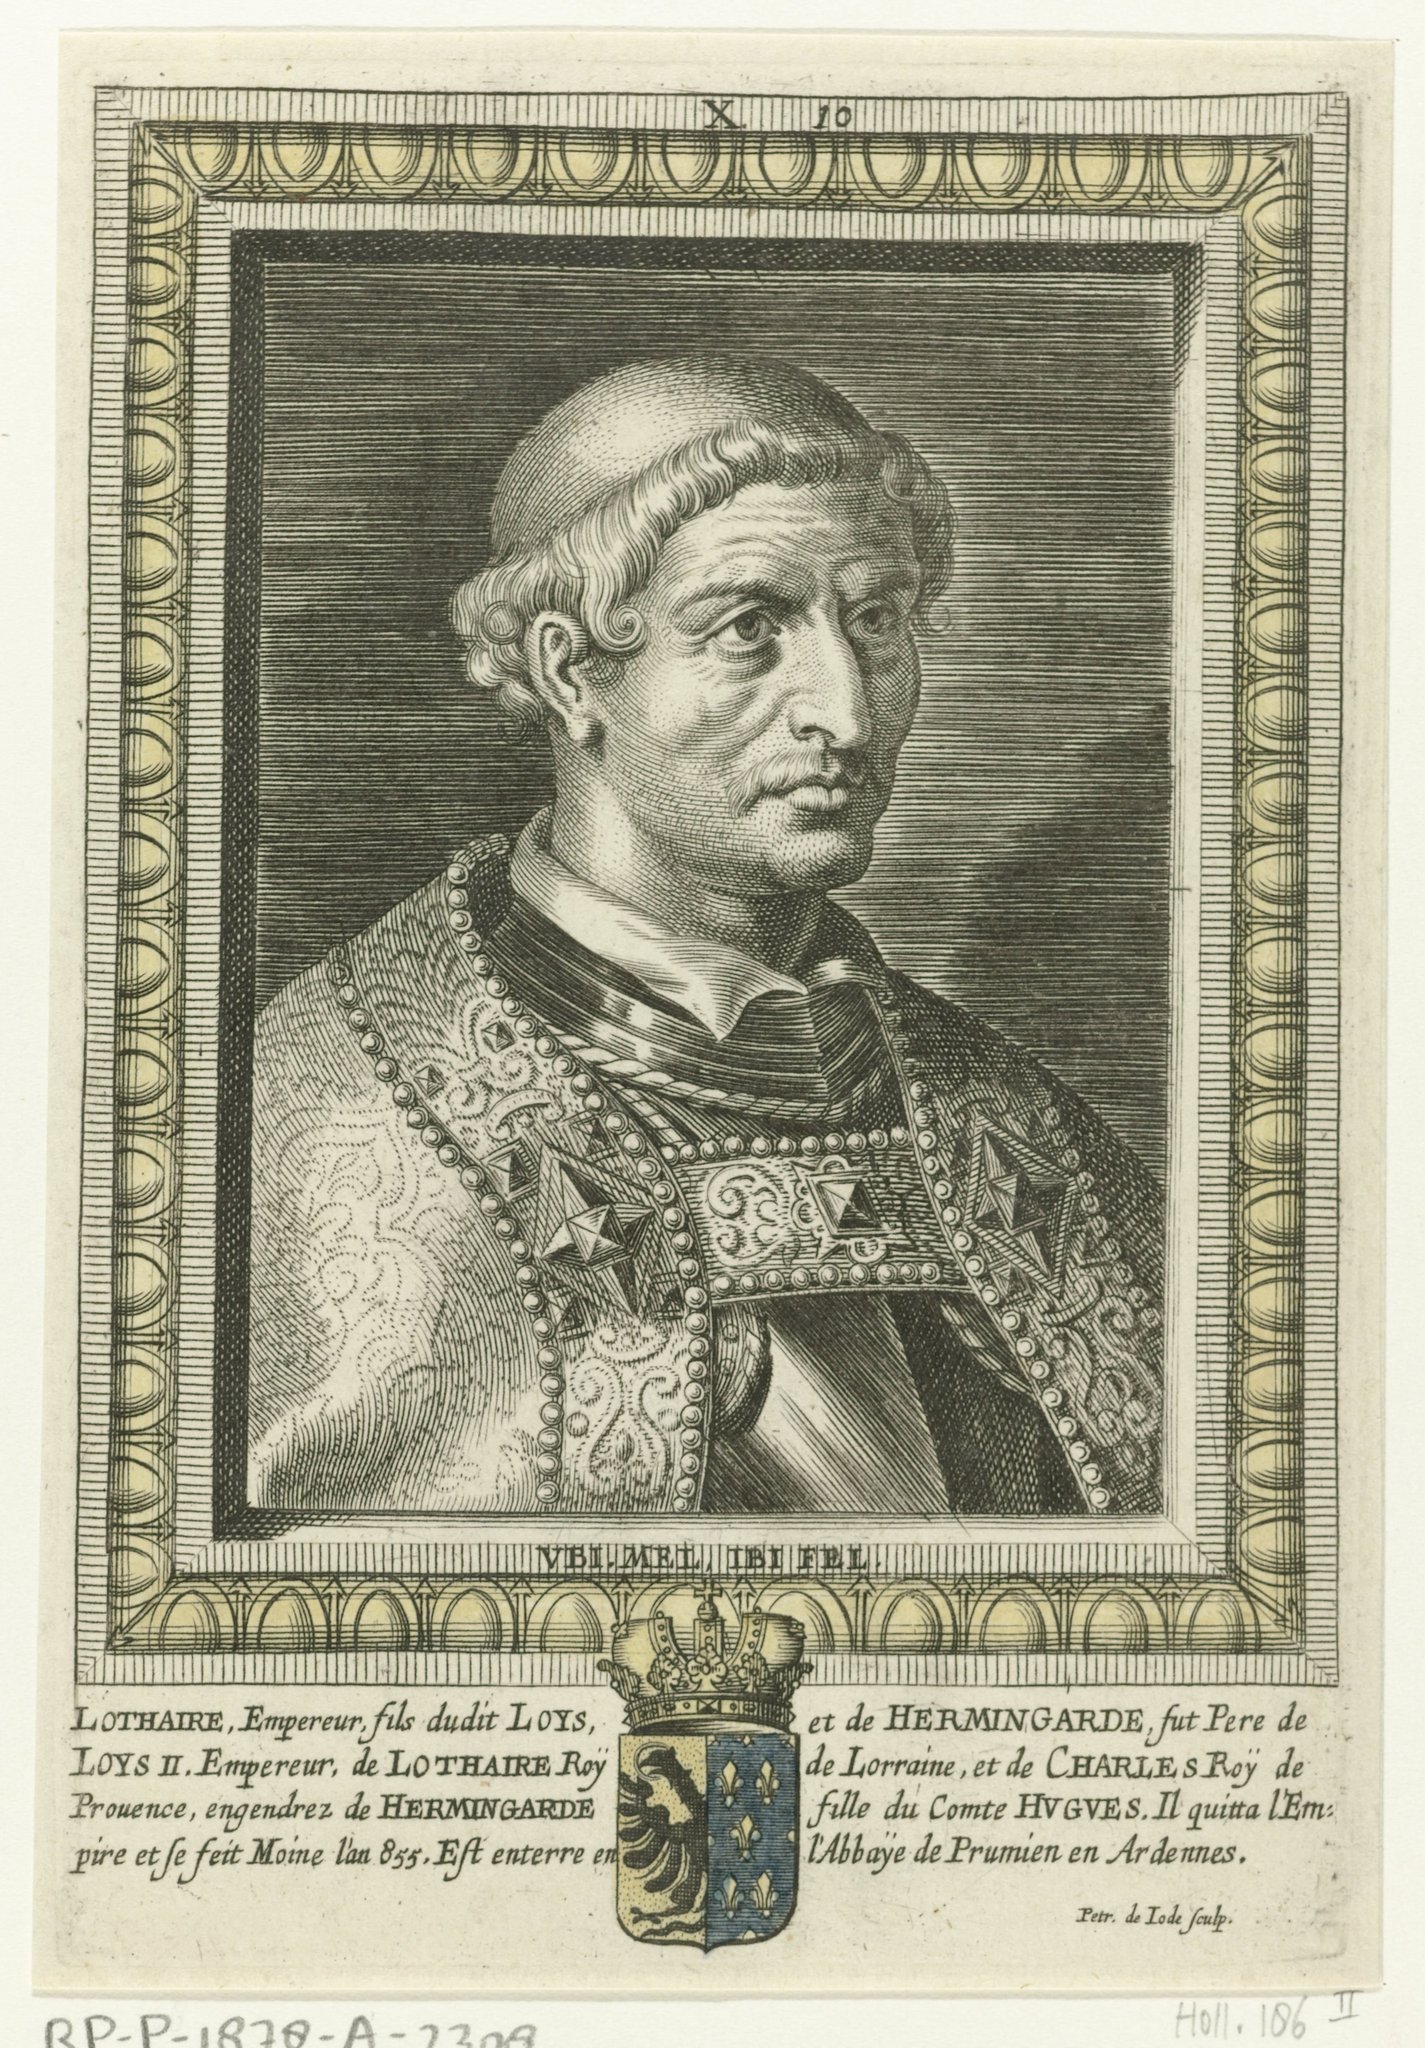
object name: book illustration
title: Portret van Lotharius I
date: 1661-1663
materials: paper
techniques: engraving, etching, hand coloring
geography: antwerp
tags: keizer, lotharius i (keizer van het heilige roomse rijk)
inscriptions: collector's mark: Lugt 2228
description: Busteportret van Lotharius I, met rijk versierde mantel. Het portret is gevat in een rechthoekige omlijsting met een motto in het Latijn. In de marge het wapenschild van de geportretteerde en een vierregelig onderschrift in het Frans. Prent uit een boek waarin 54 prenten met portretten.